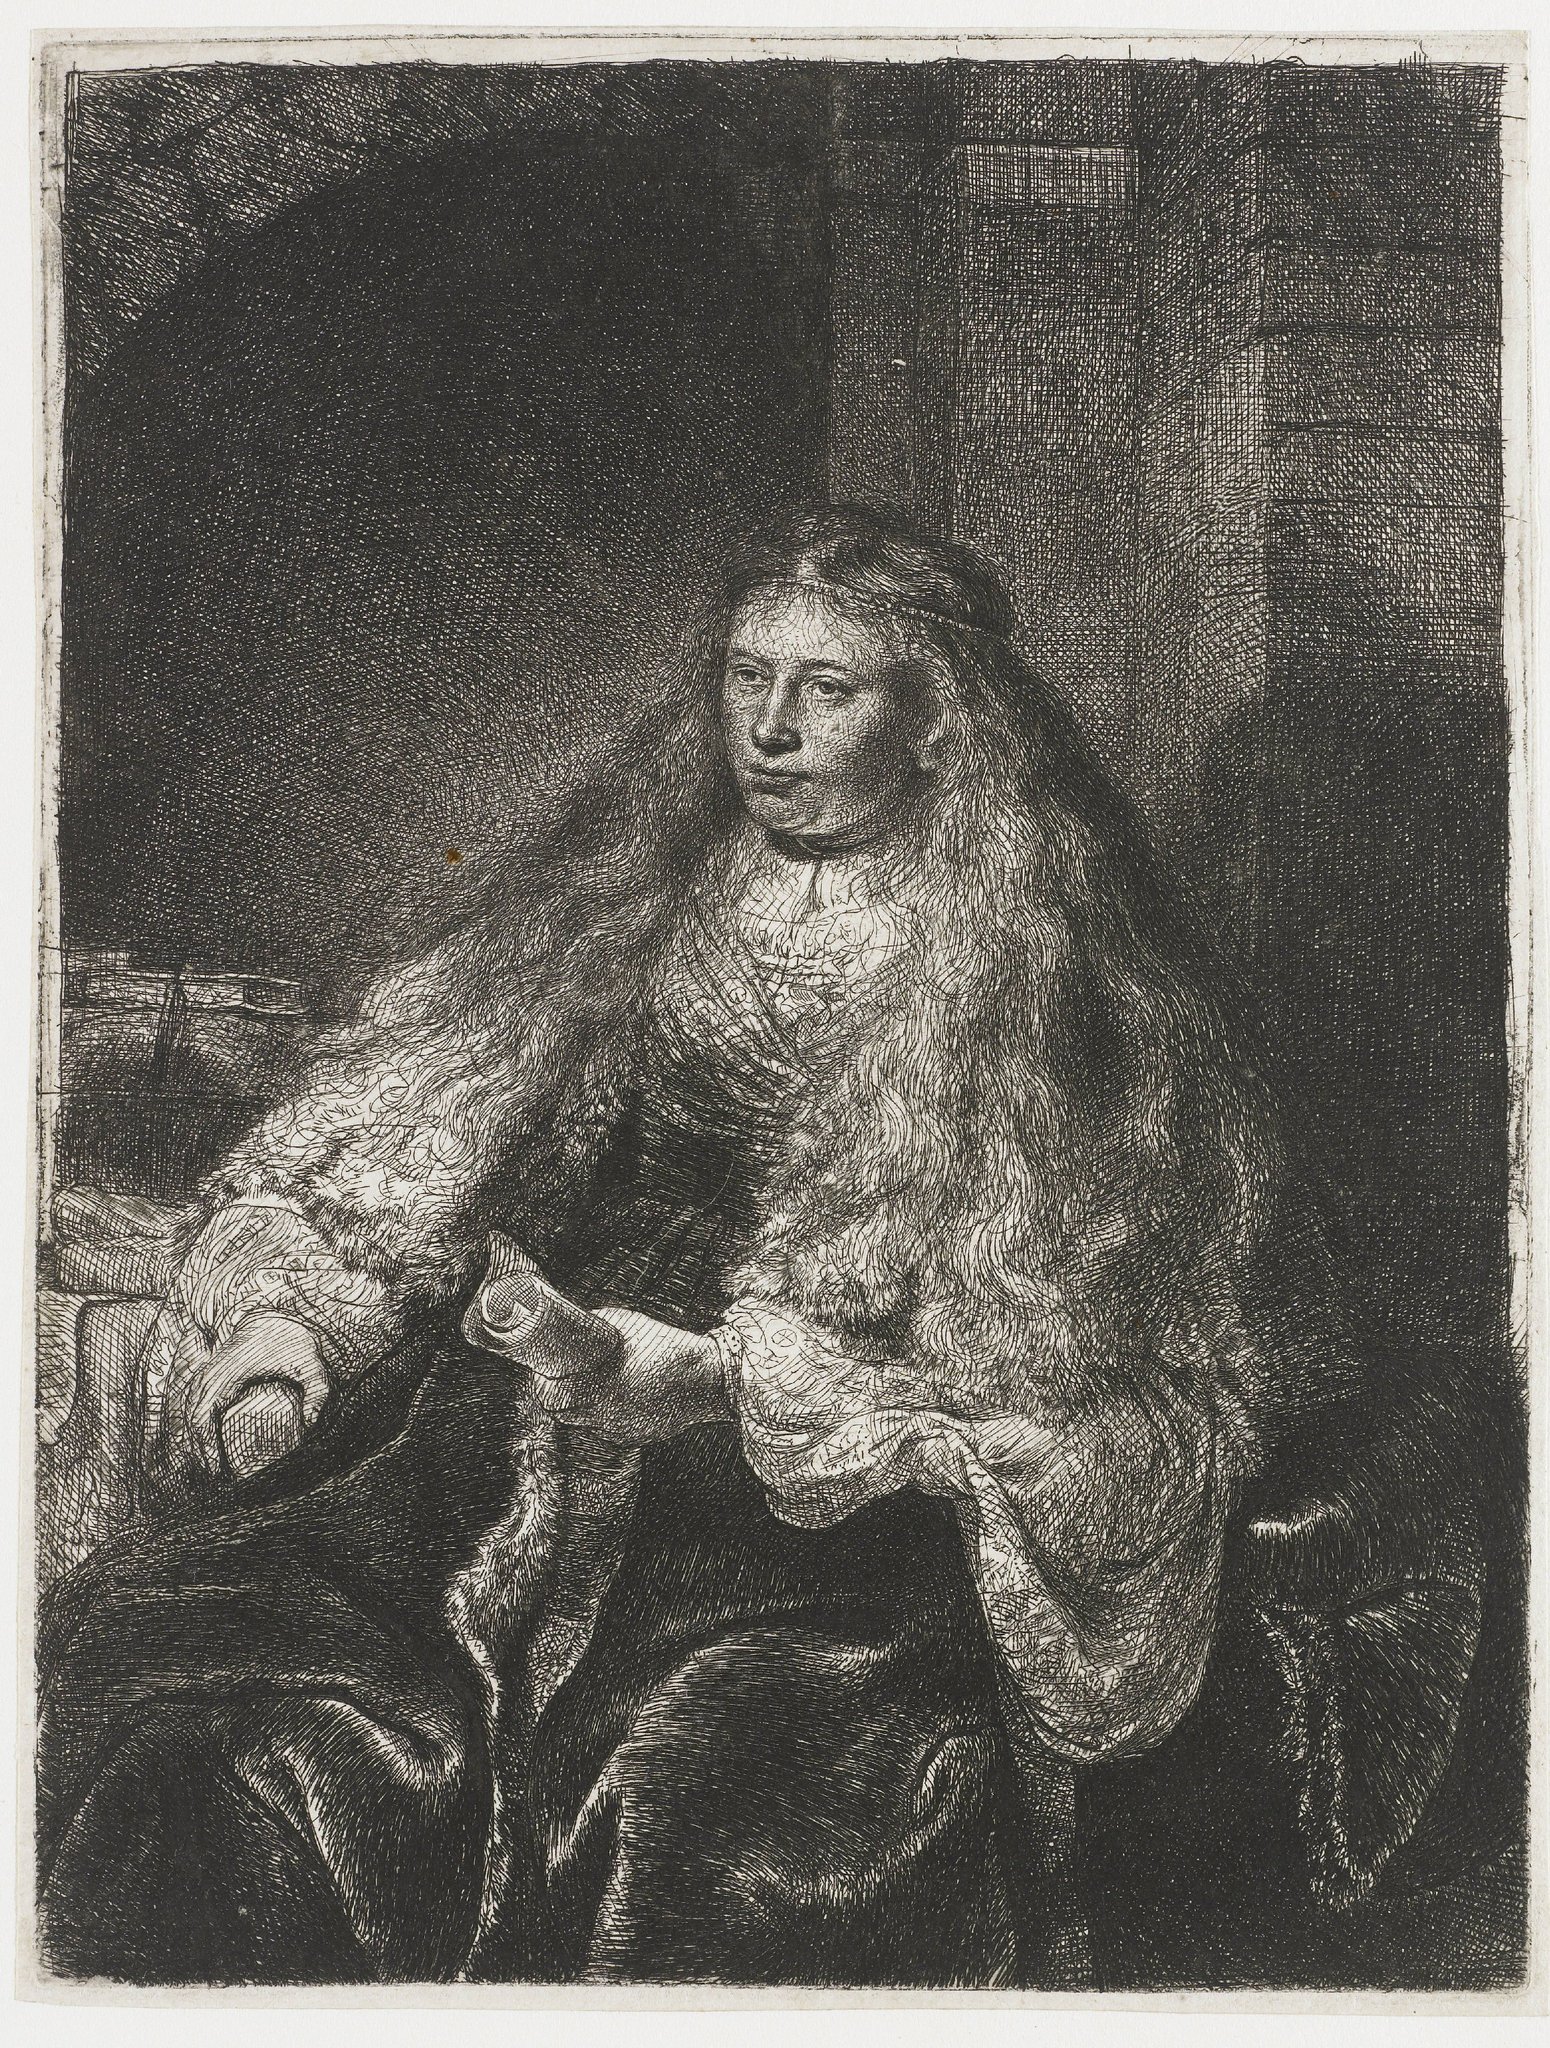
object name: print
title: The Great Jewish Bride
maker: rembrandt van rijn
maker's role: draughtsman, painter, print maker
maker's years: 1606-1669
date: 1635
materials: paper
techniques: drypoint, etching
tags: bride (in wedding-dress)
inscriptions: monogram and date: ‘R 1635’, collector's mark: Lugt 240, inscription: ‘2 __ 0’, inscription: ‘diverse geometrische figuren’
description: Why this print is traditionally called The Jewish Bride is uncertain. It probably depicts Rembrandt’s wife, Saskia, in the guise of a biblical figure: the Jewish queen Esther, who would beseech her husband, the Persian king Ahasuerus, to save her people. Here she holds the order to kill the Jews issued by Haman, her husband’s vizier. In the end, Ahasuerus did not consent, and ignored the order.